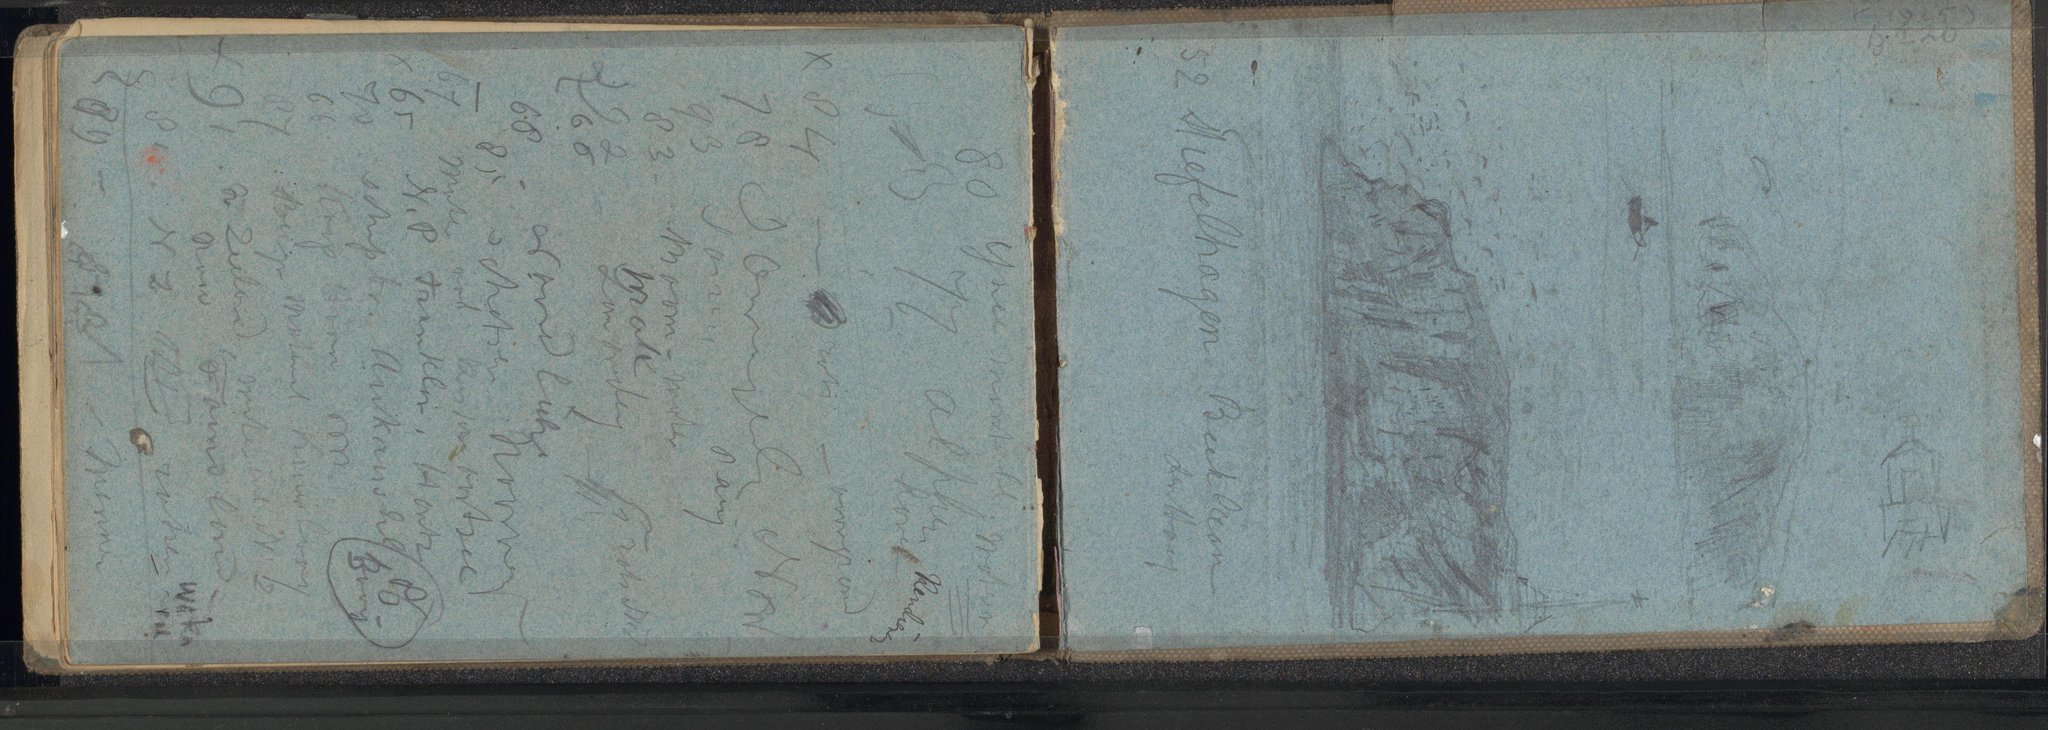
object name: sketchbook leaf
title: Twee kustgezichten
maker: louis apol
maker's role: draughtsman, painter, print maker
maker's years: 1850-1936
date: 1880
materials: paper, pencil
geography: novaya zemlya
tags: coast (in polar regions), rowing-boat, canoe, etc.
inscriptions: annotation: ‘52 Stiefelhagen Beeklaan/ Den Haag’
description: Schutblad B, achterste schutblad, uit een schetsboek met 38 bladen betekend tijdens de expeditie naar Nova Zembla in 1880.